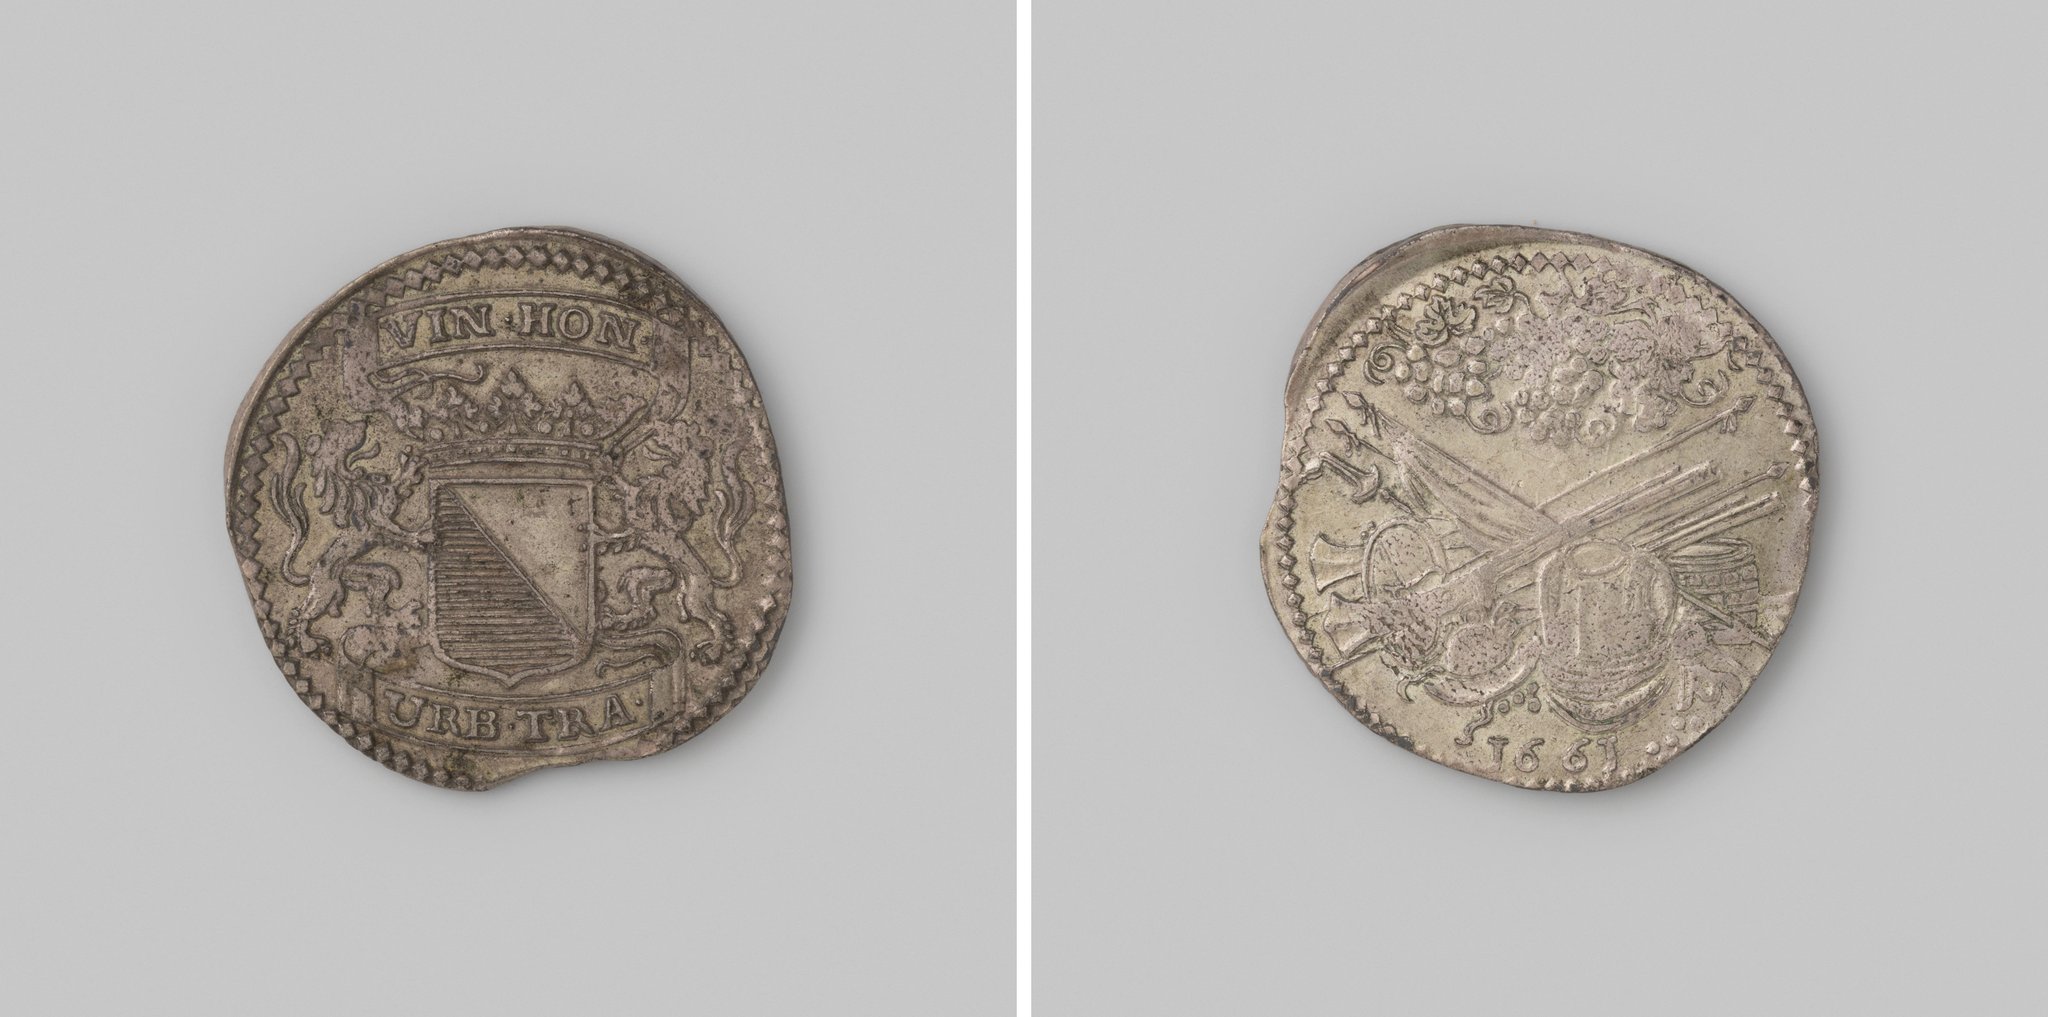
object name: marksman medal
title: Wijnpenning van Utrecht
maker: Anonymous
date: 1661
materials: silver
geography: utrecht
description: Zilveren wijn- en schutterspenning van Utrecht. Voorzijde: het stadswapen met leeuwen als schildhouders en kroon. Boven in een banderol: VIN [um] HON [orarium]. Onderaan: URB [is] TRA [jectensis] (erewijn der stad Utrecht). Keerzijde: verschillende trofeeën met daarboven een grote druiventros. Onderaan het jaartal 1661.